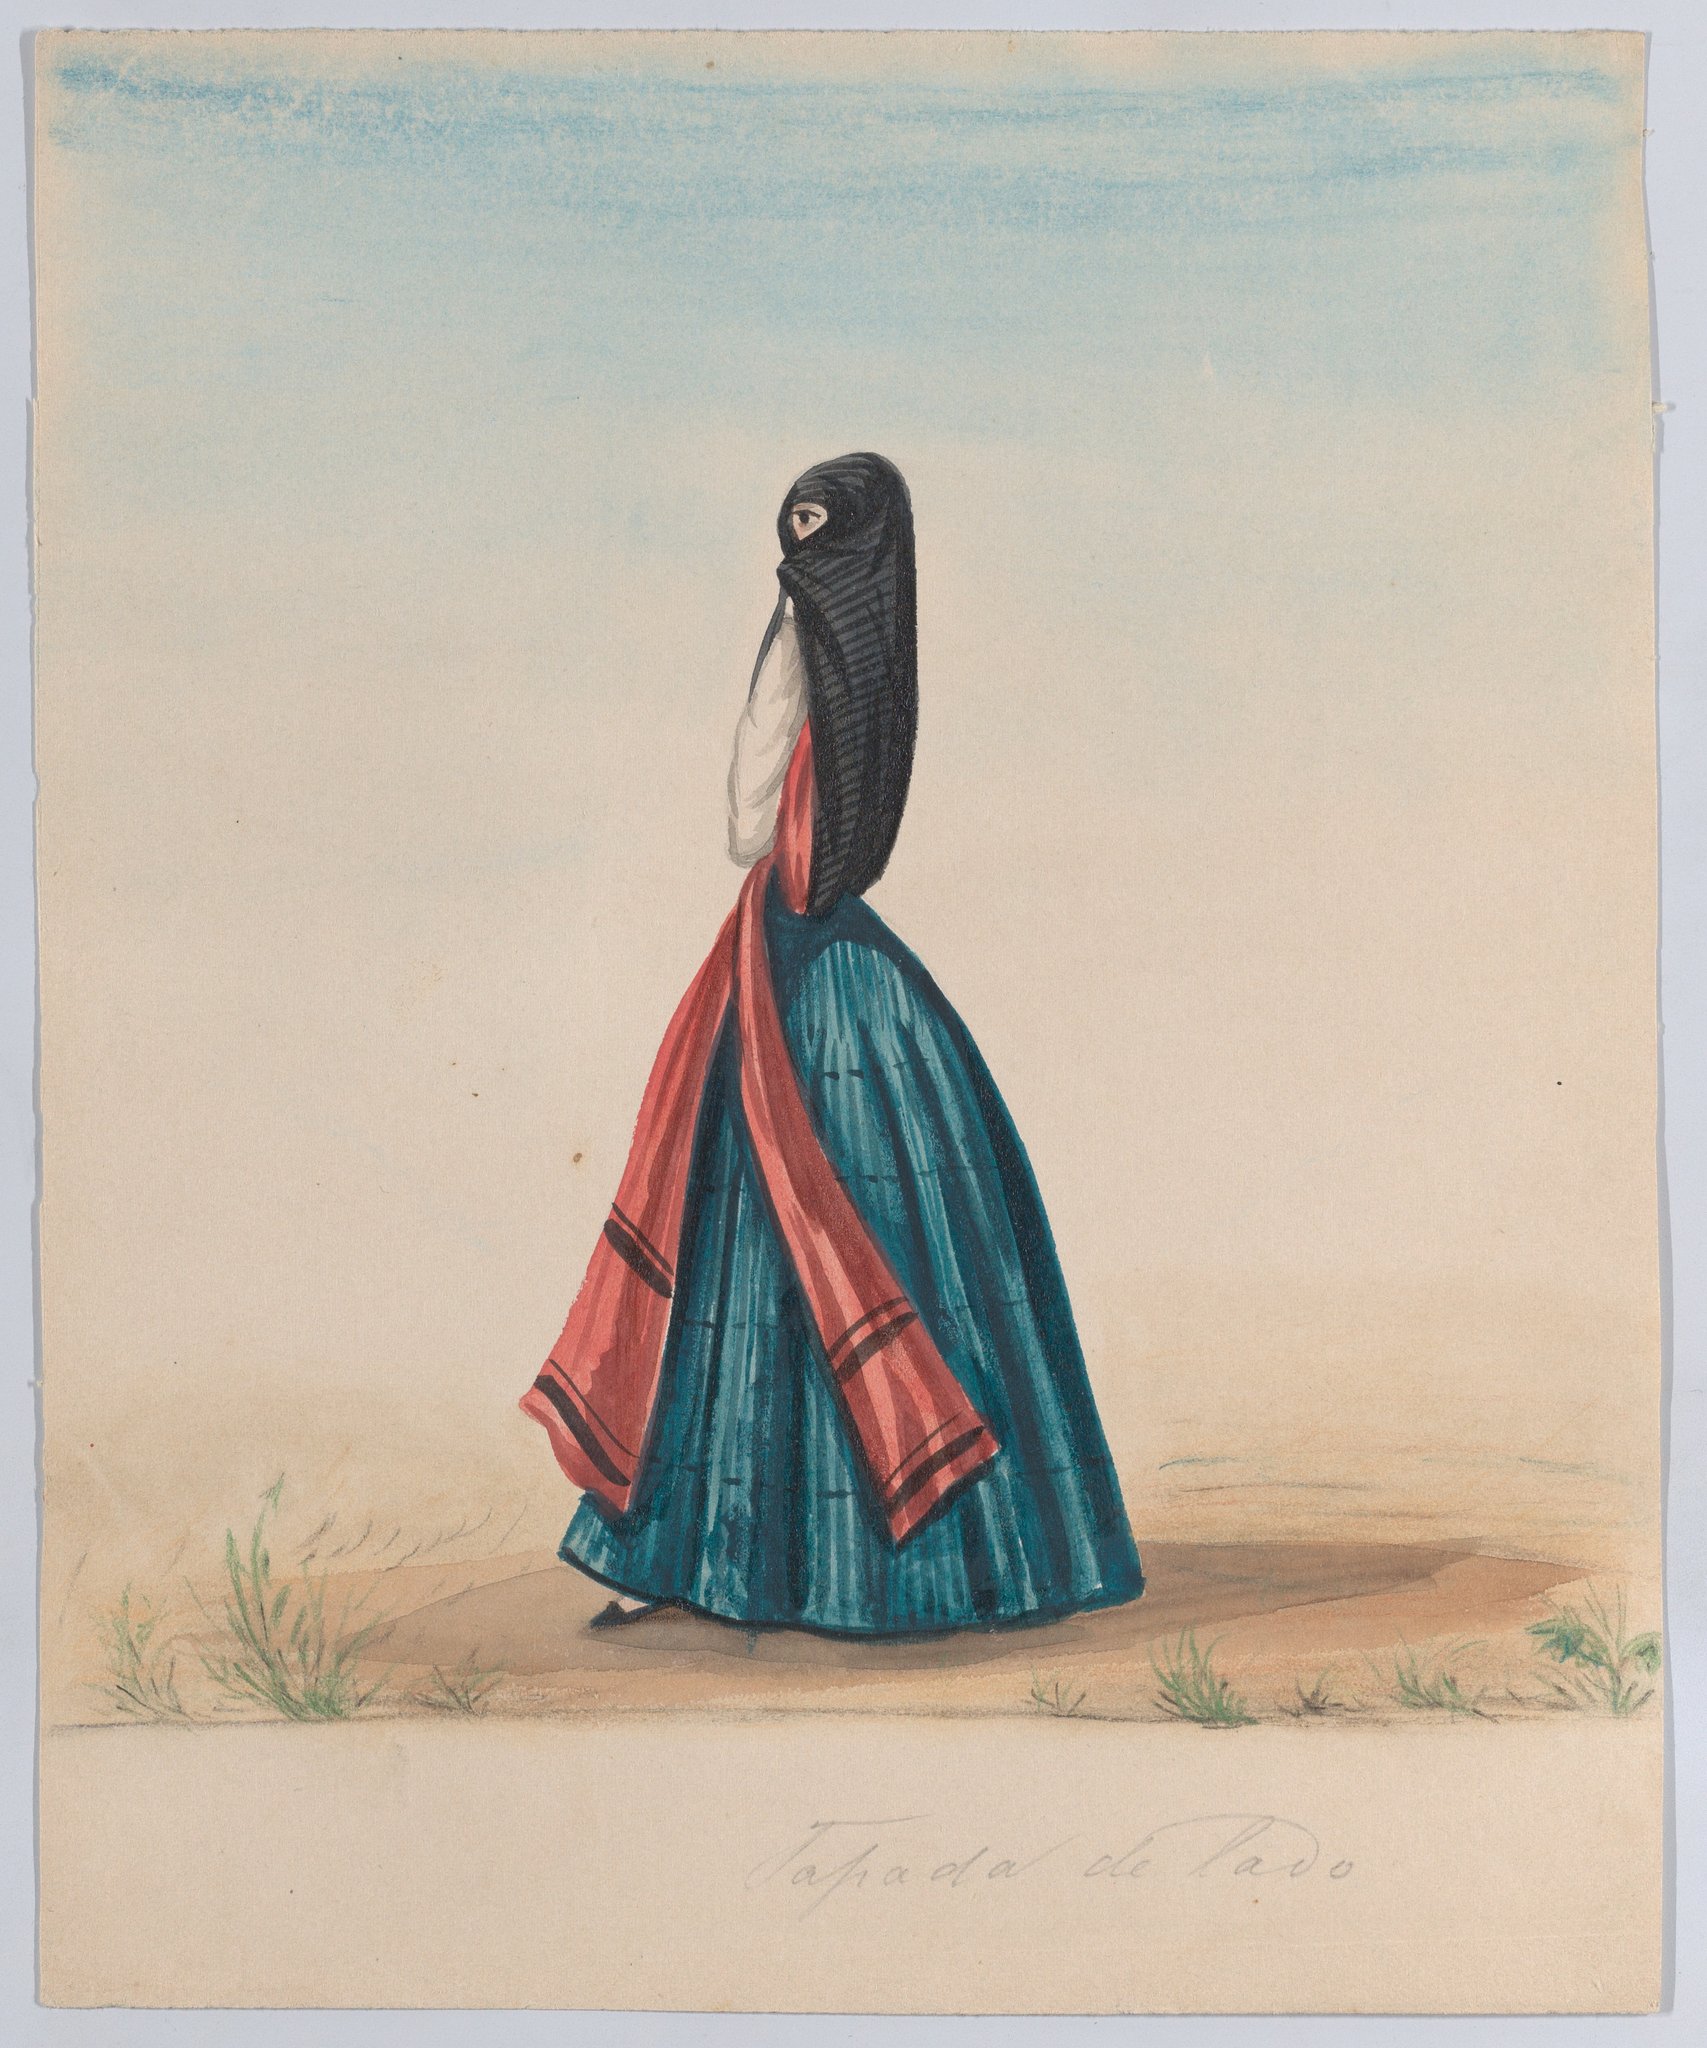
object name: drawing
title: A woman wearing the saya and manto standing in profile, from a group of drawings depicting Peruvian dress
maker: francisco (pancho) fierro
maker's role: artist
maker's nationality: african peruvian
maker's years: 1807-1879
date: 1848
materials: watercolor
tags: women